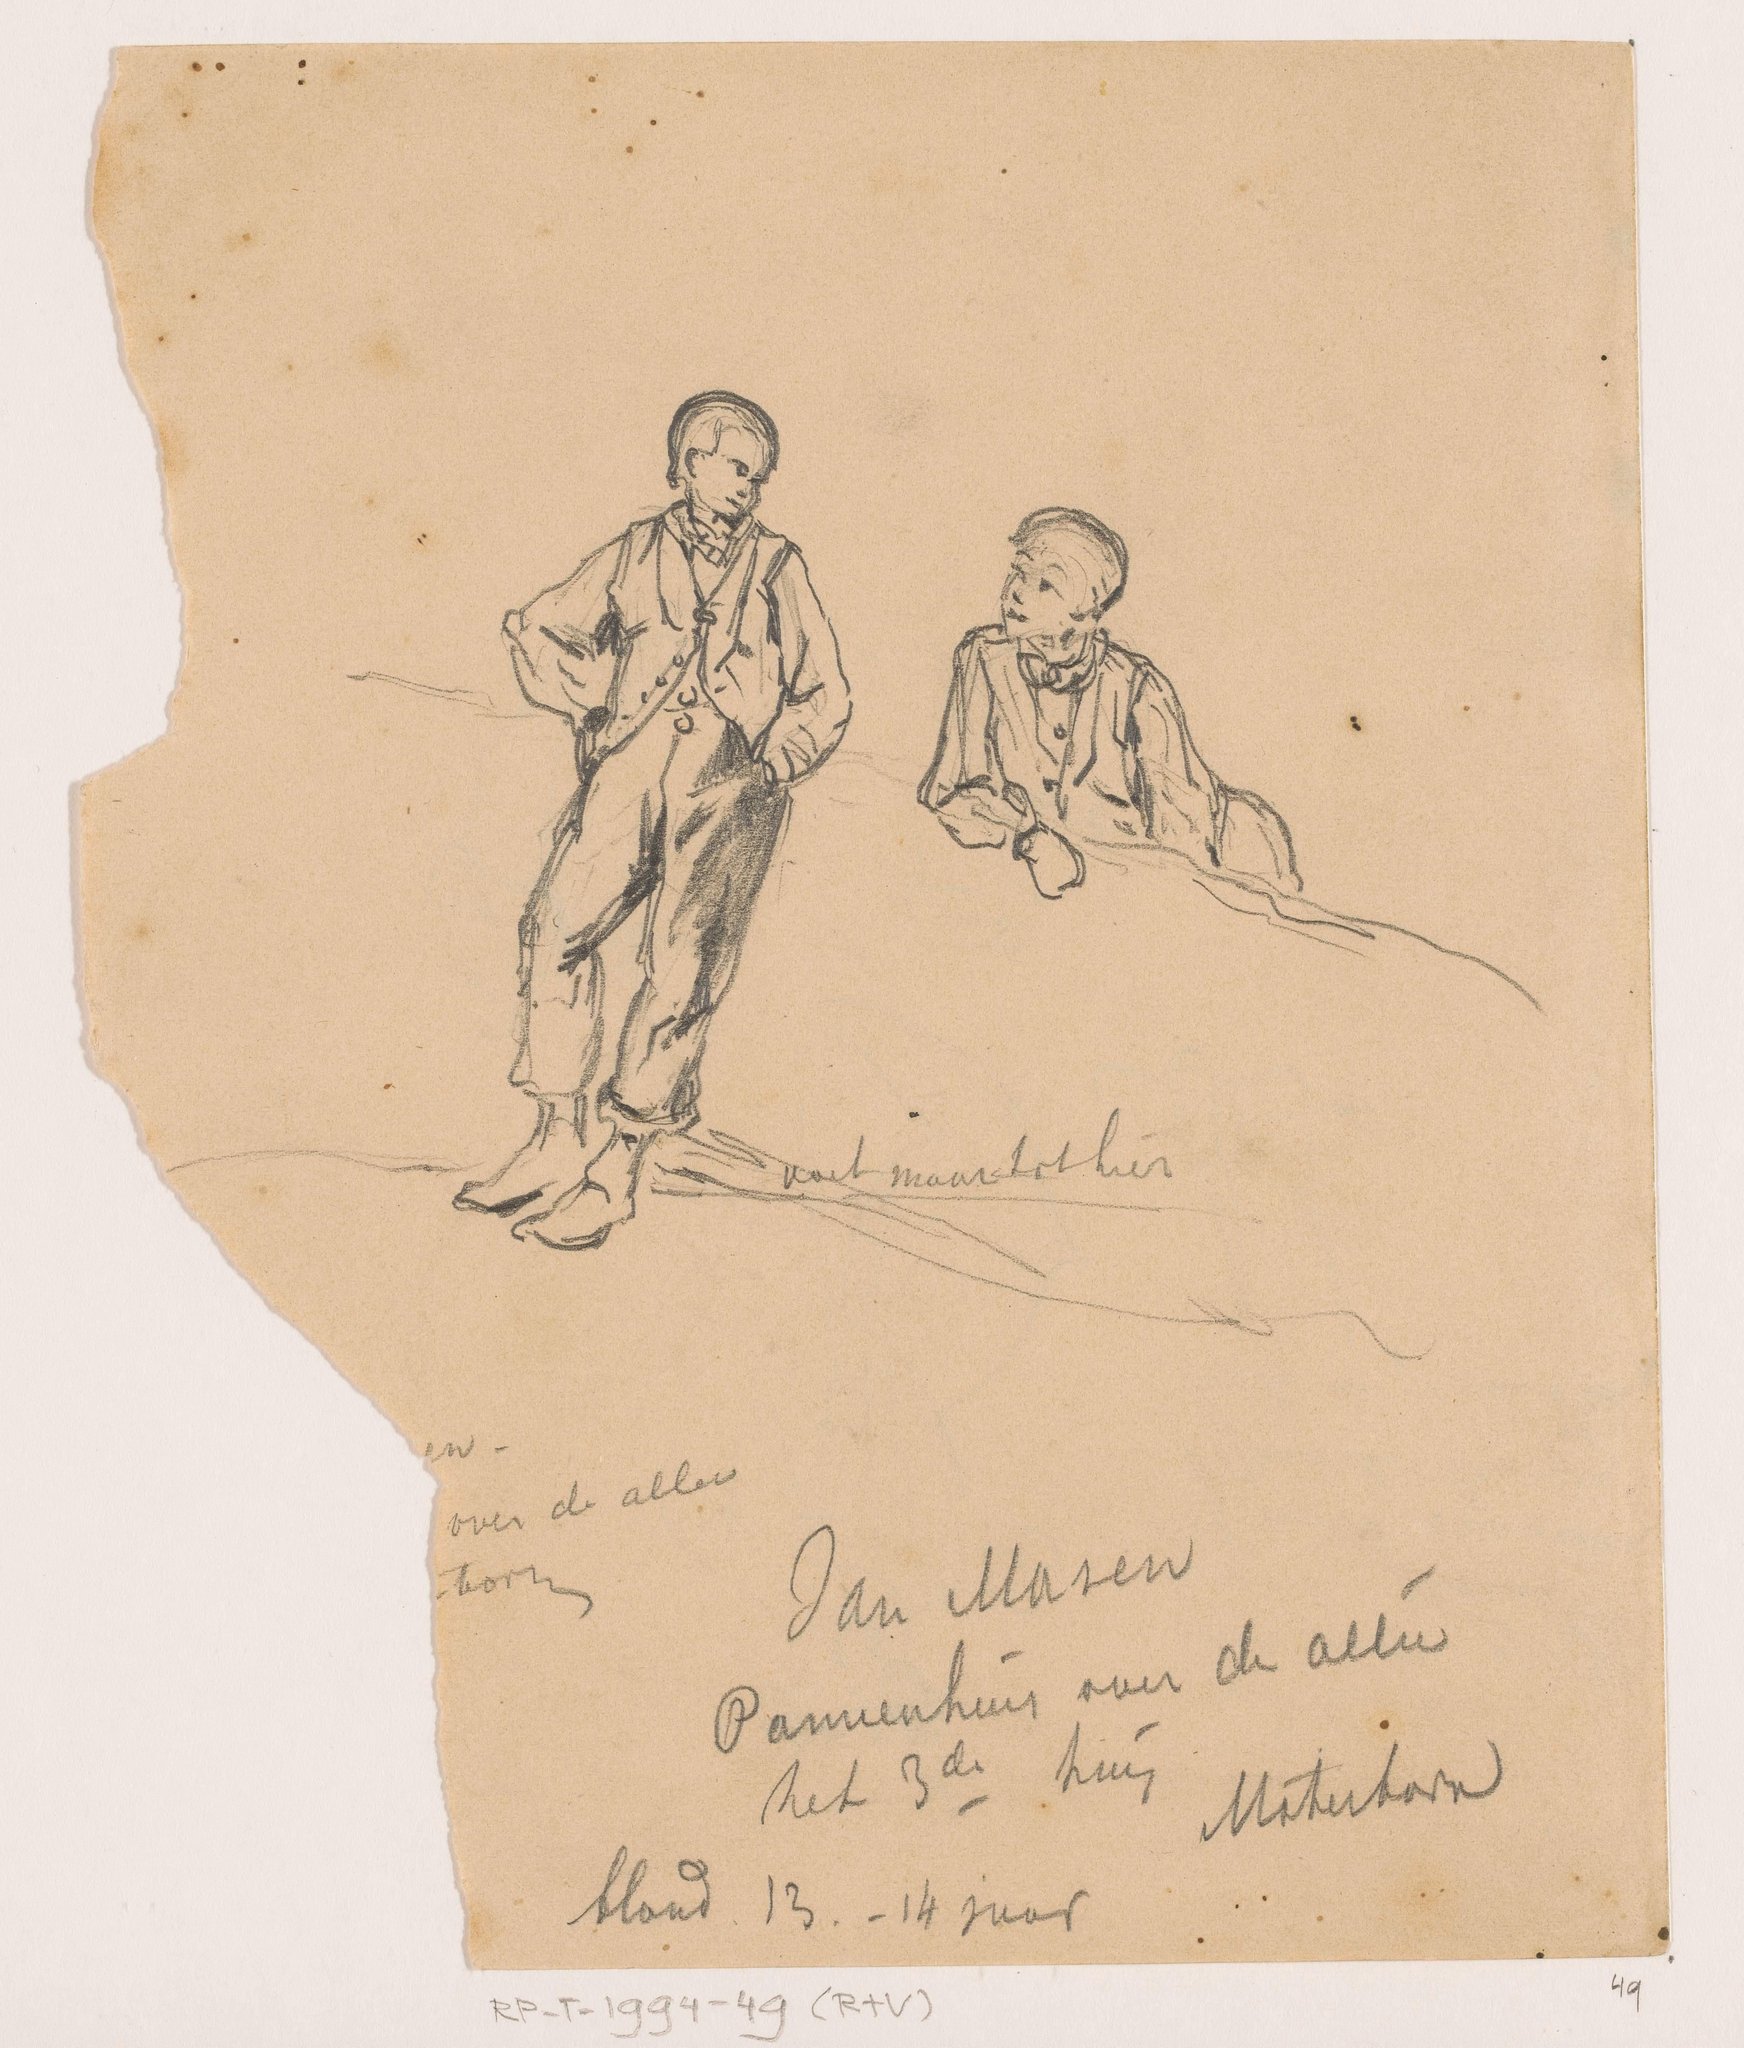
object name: drawing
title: Twee schetsjes van een jongen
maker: johannes tavenraat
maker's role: draughtsman, painter, print maker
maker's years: 1809-1881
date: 1846-1860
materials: paper, pencil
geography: materborn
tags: boy (child between toddler and youth)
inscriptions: inscription: ‘Jan Maren / Pannenhuis over de allée / het 3de huis Materborn / blond 13. - 14 jaar’, inscription: ‘voet maar tot hier’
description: Twee schetsjes van een jongen, volgens het opschrift genaamd Jan Maren, in het dorp Materborn.